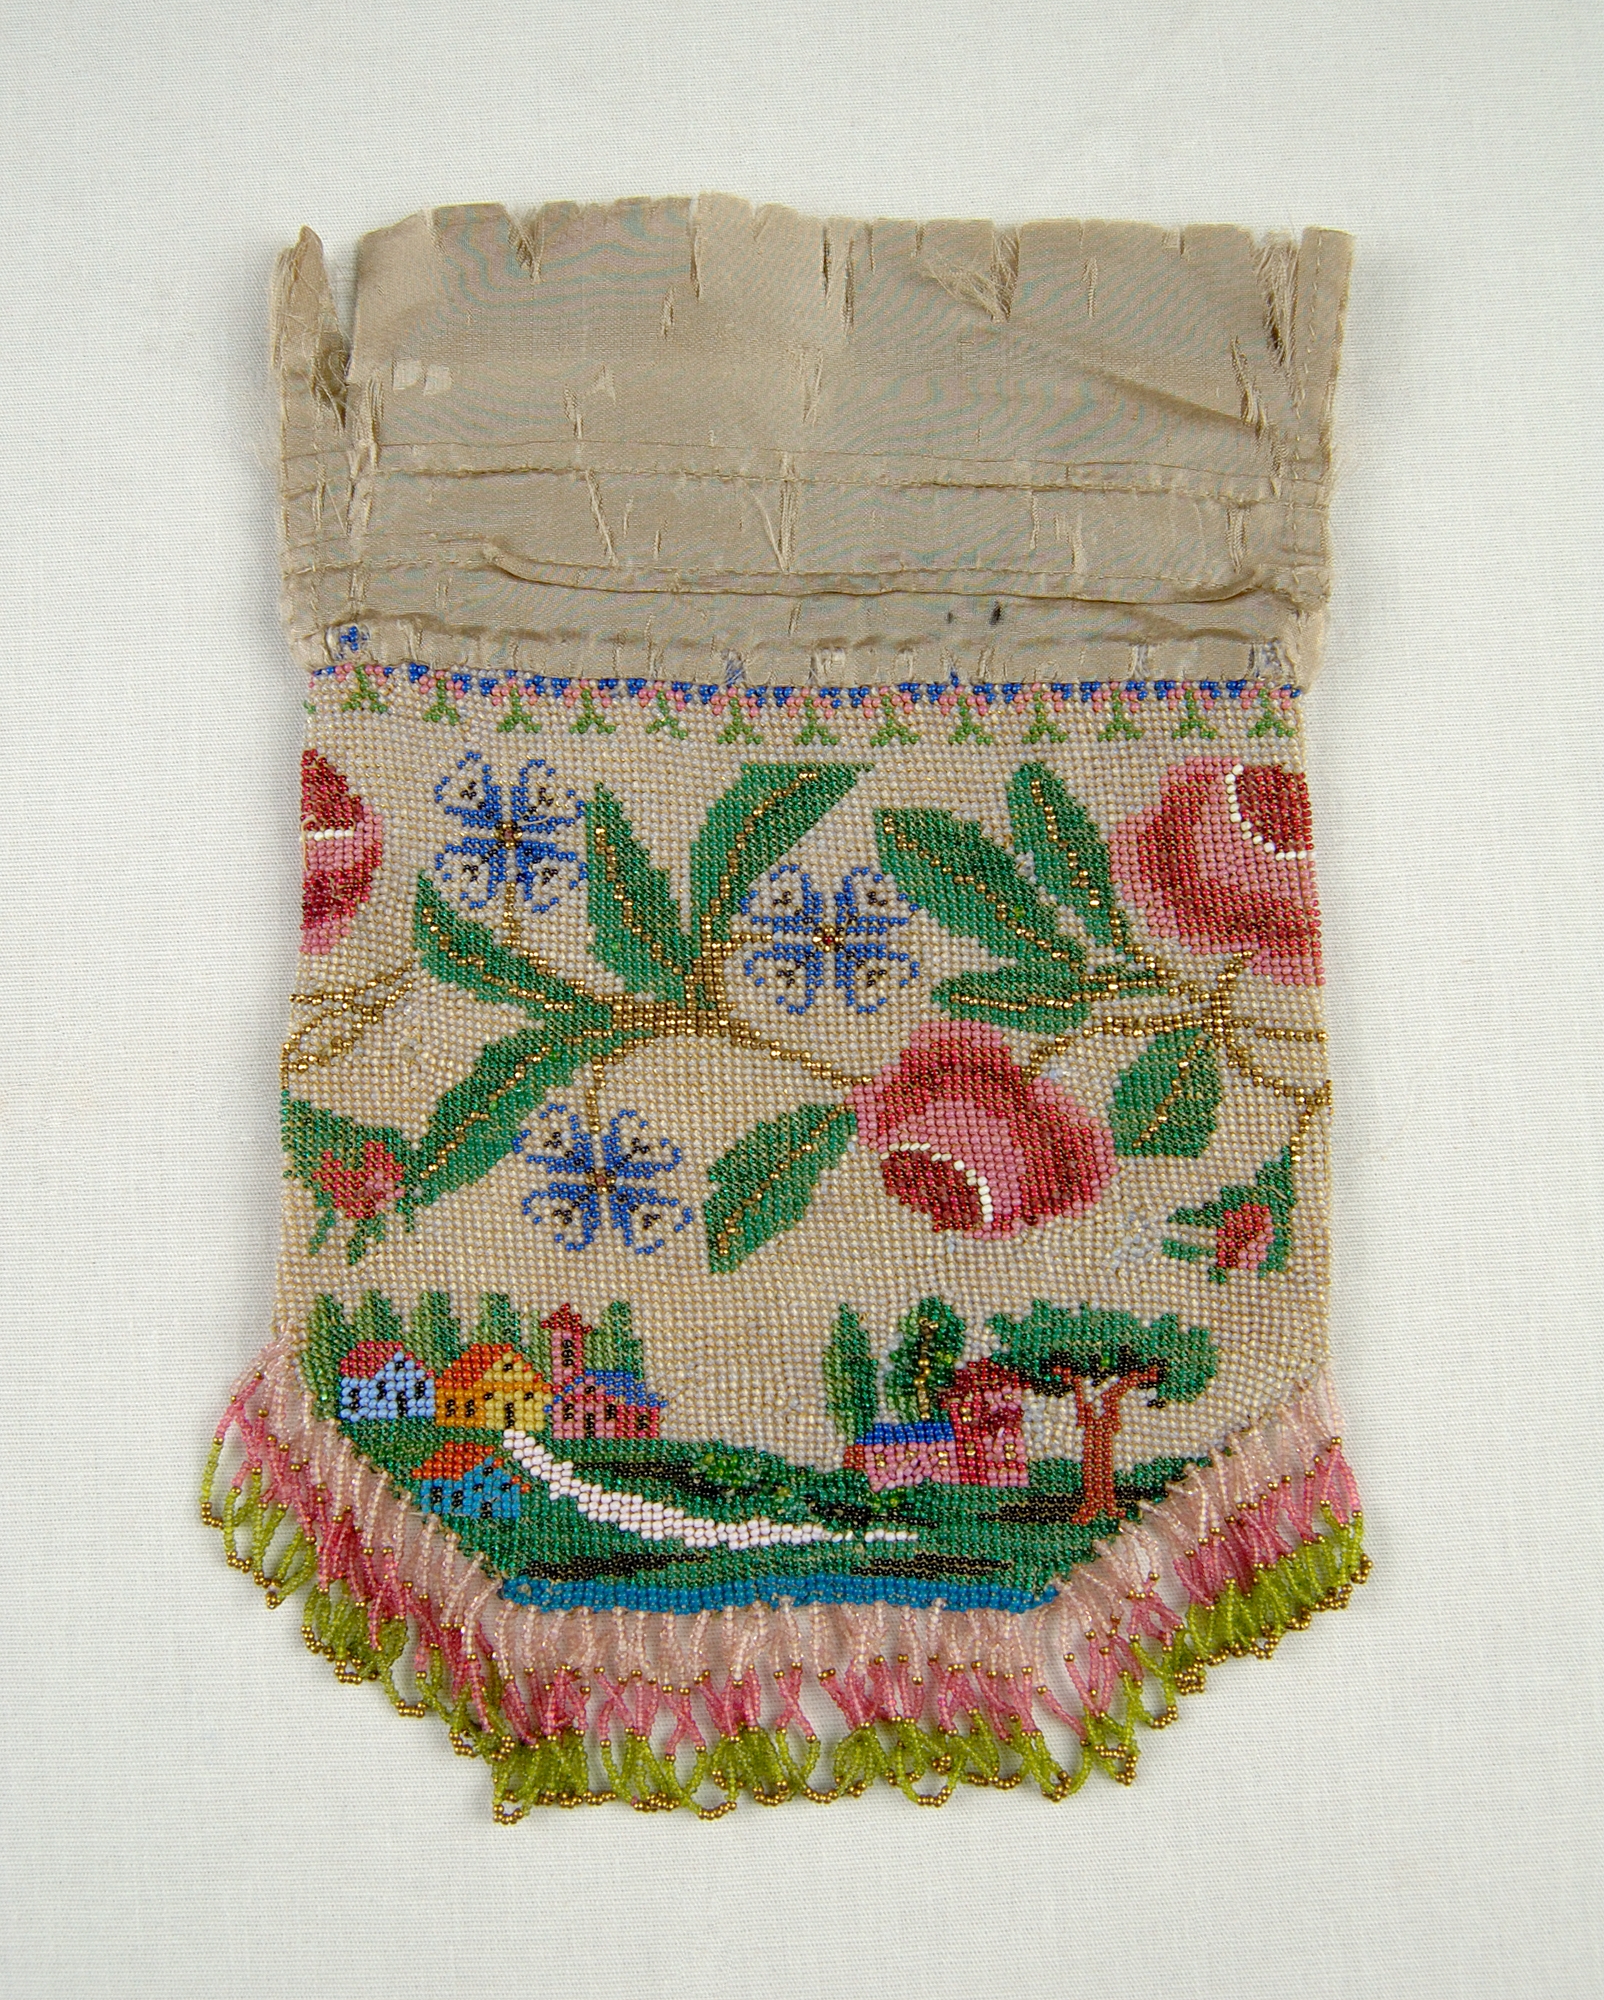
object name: pouch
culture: american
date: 1840-1860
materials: glass, linen, silk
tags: houses,flowers,trees